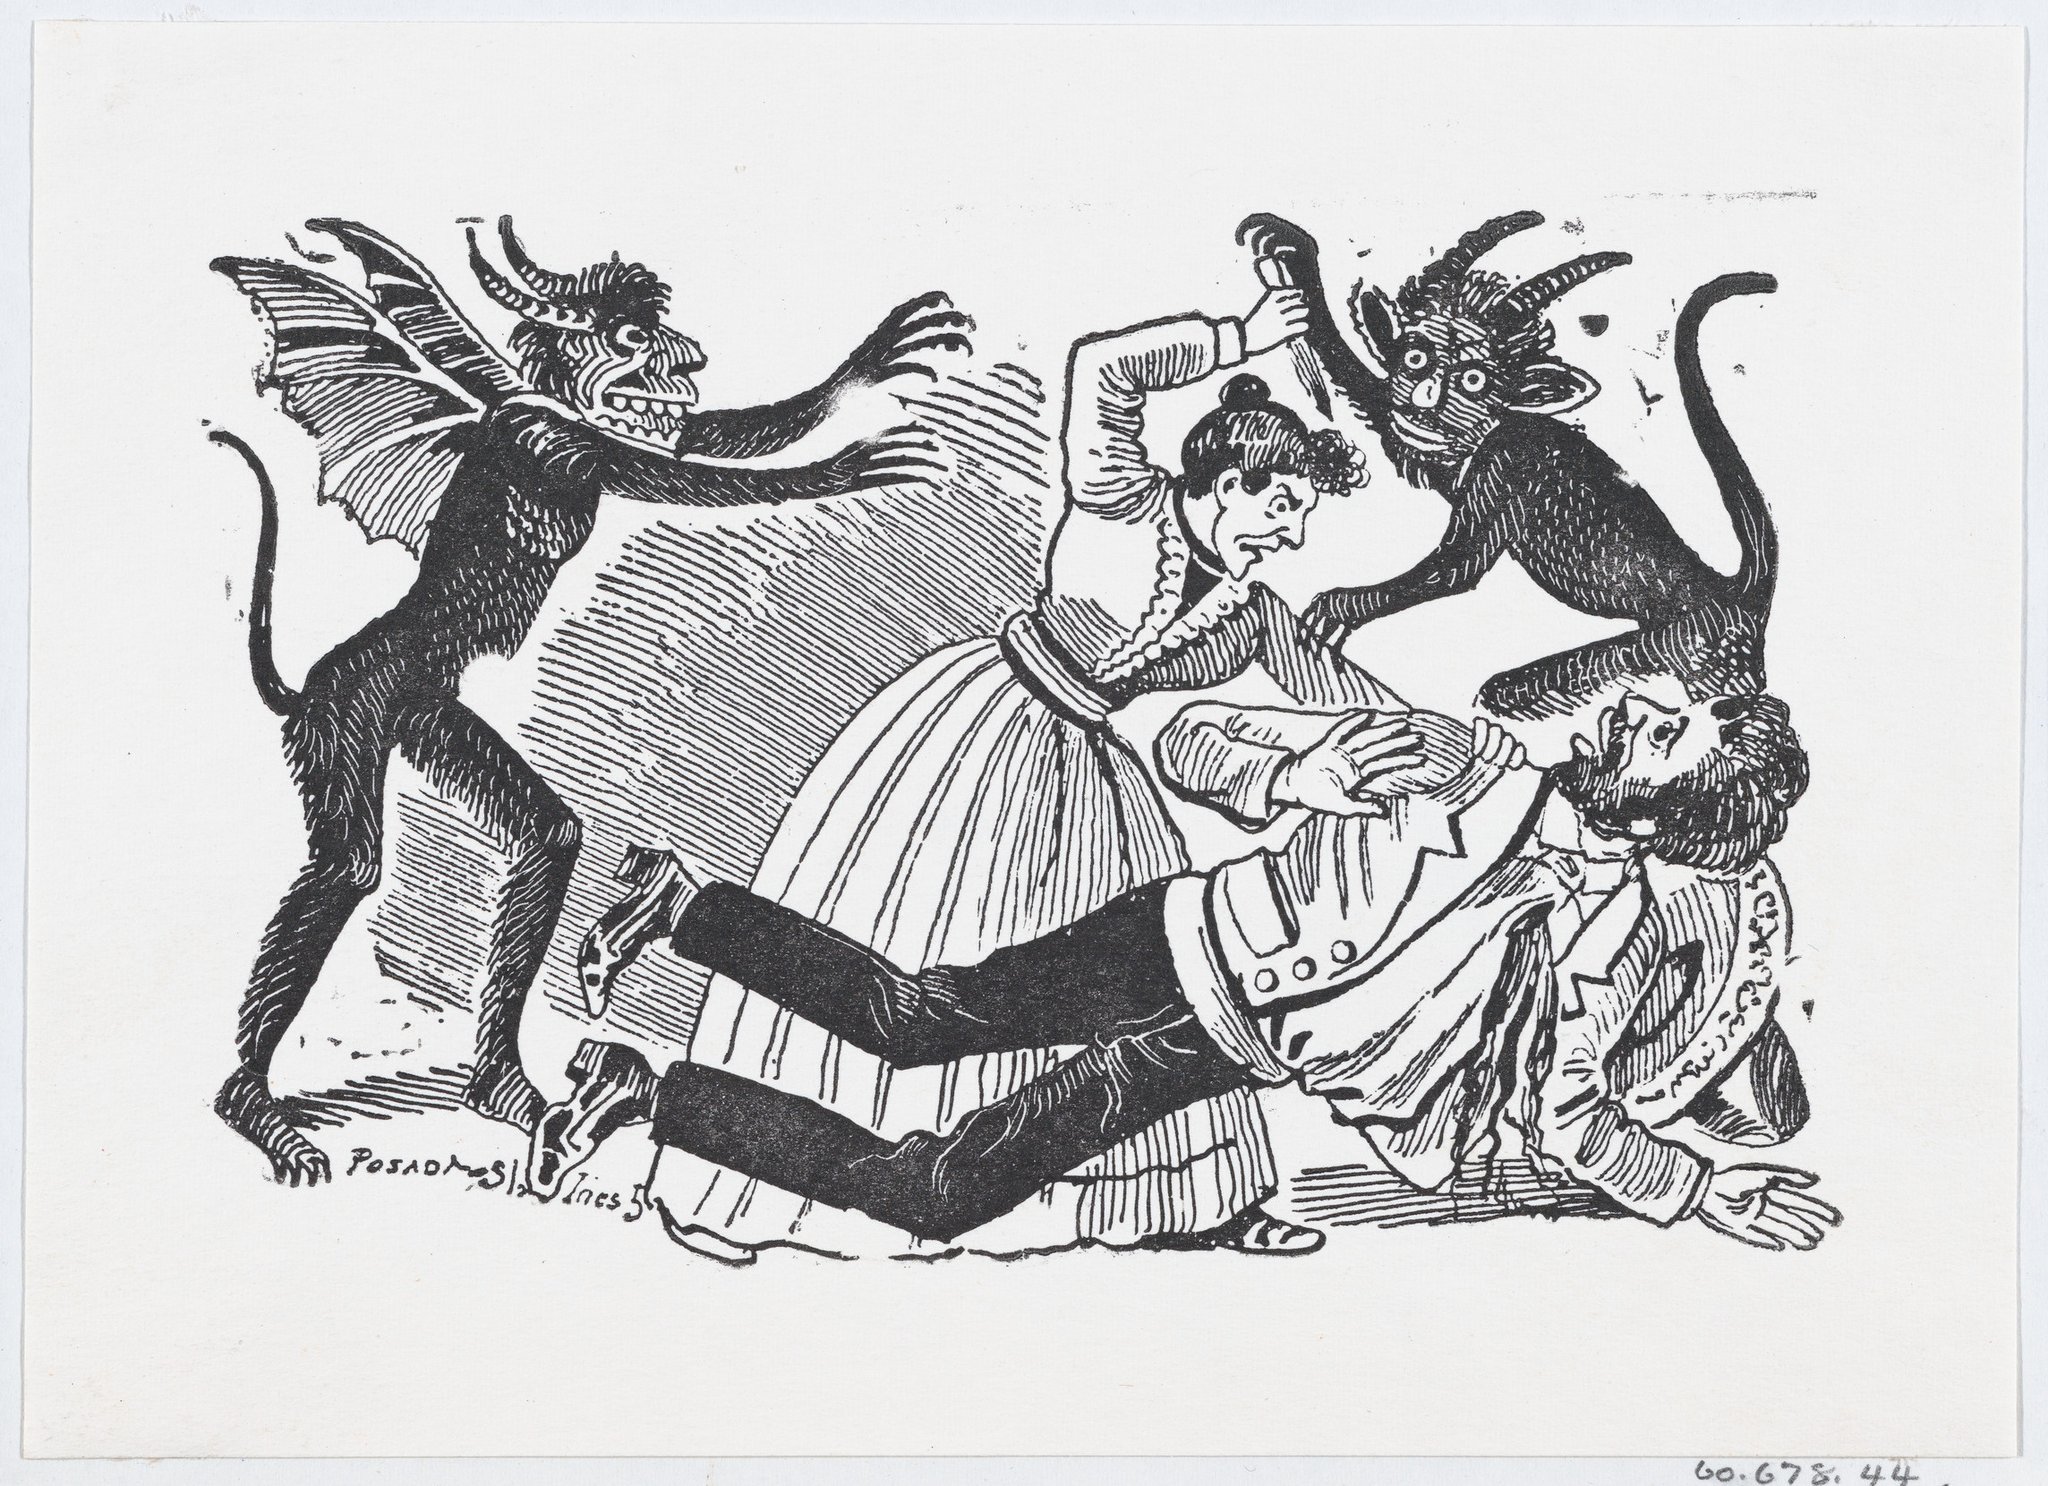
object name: print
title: A woman surrounded by demons stabbing a man to death from a broadside entitled 'Horroroso Asesinato'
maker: josé guadalupe posada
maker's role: artist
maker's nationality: mexican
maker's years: 1852-1913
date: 1902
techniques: lithography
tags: men,women,demons